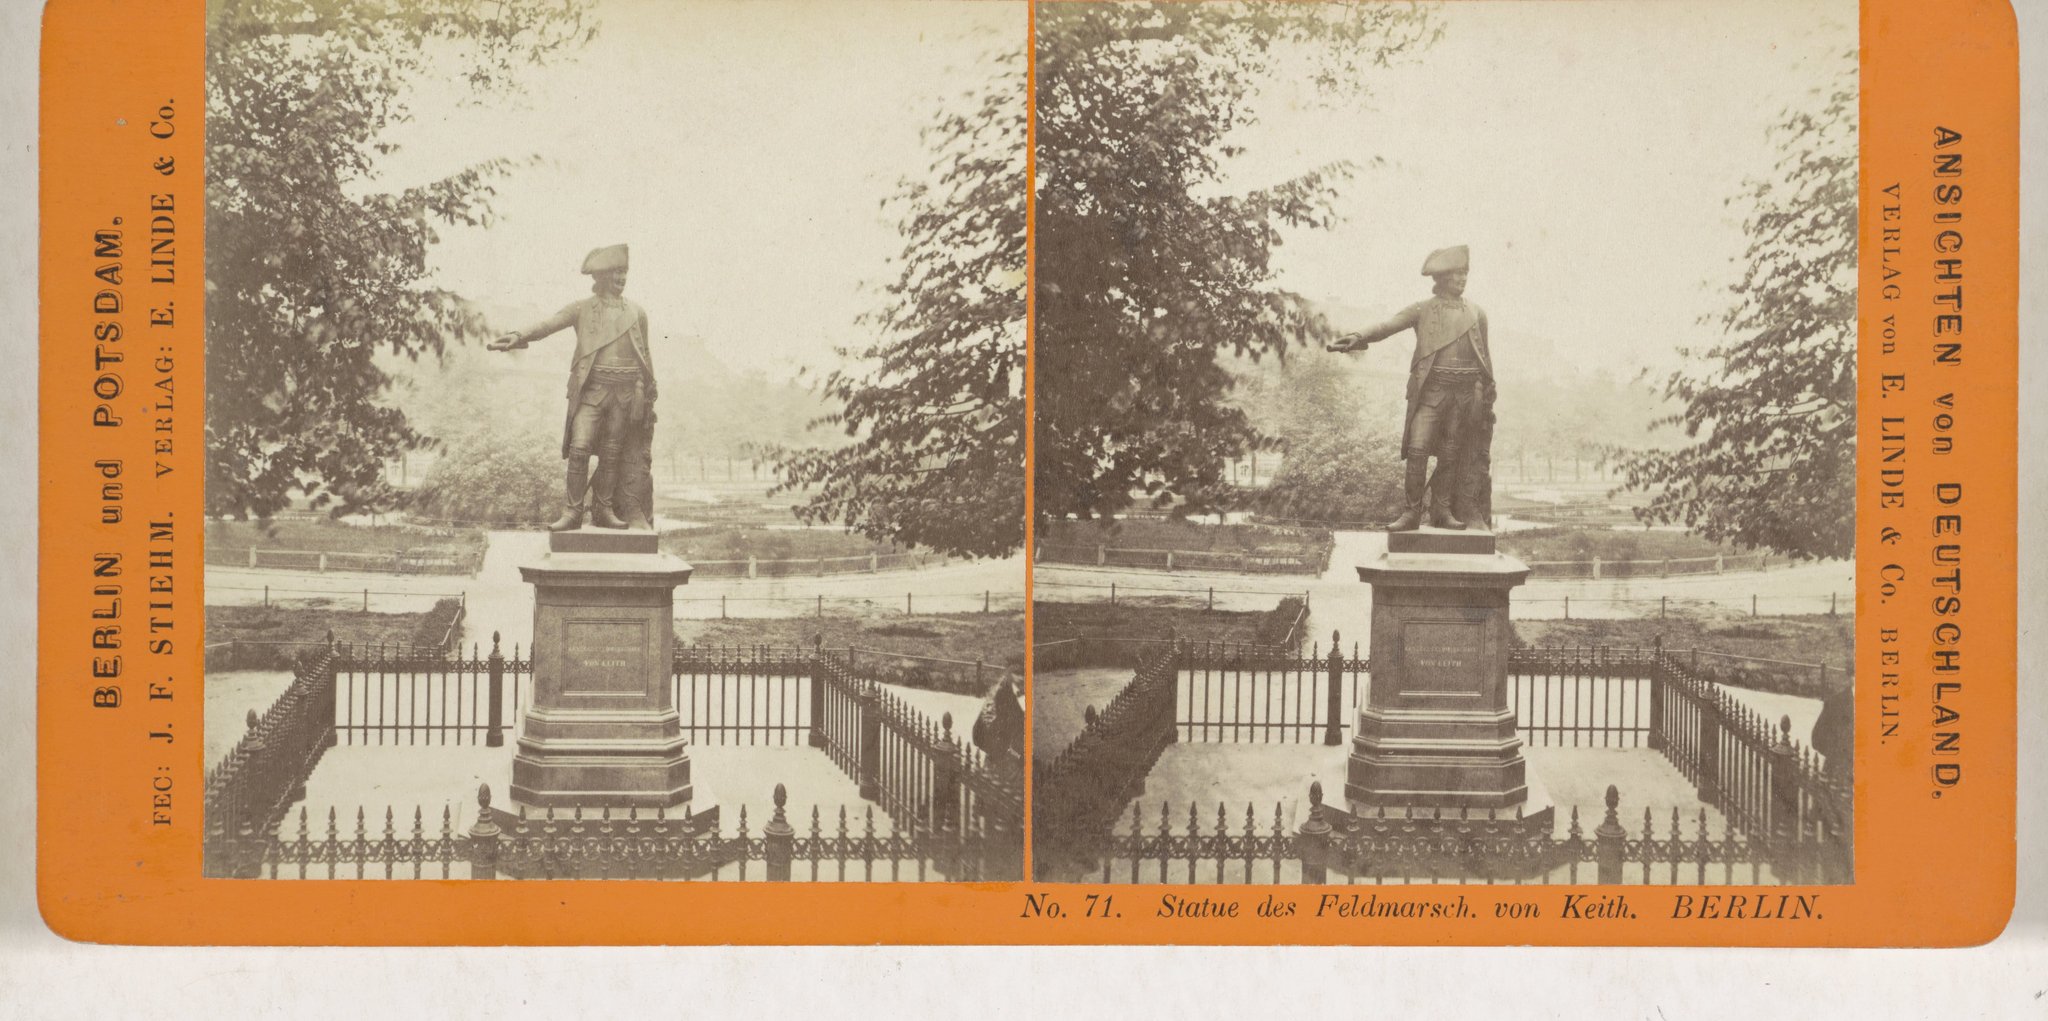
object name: stereograph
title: Standbeeld van veldmaarschalk James Francis Edward Keith op het Wilhelmplatz, Berlijn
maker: johann friedrich stiehm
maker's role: fotograaf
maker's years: 1826-1902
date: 1868-1870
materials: cardboard, paper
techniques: albumen print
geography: berlin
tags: monument, statue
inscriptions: number: ‘No. 71.’